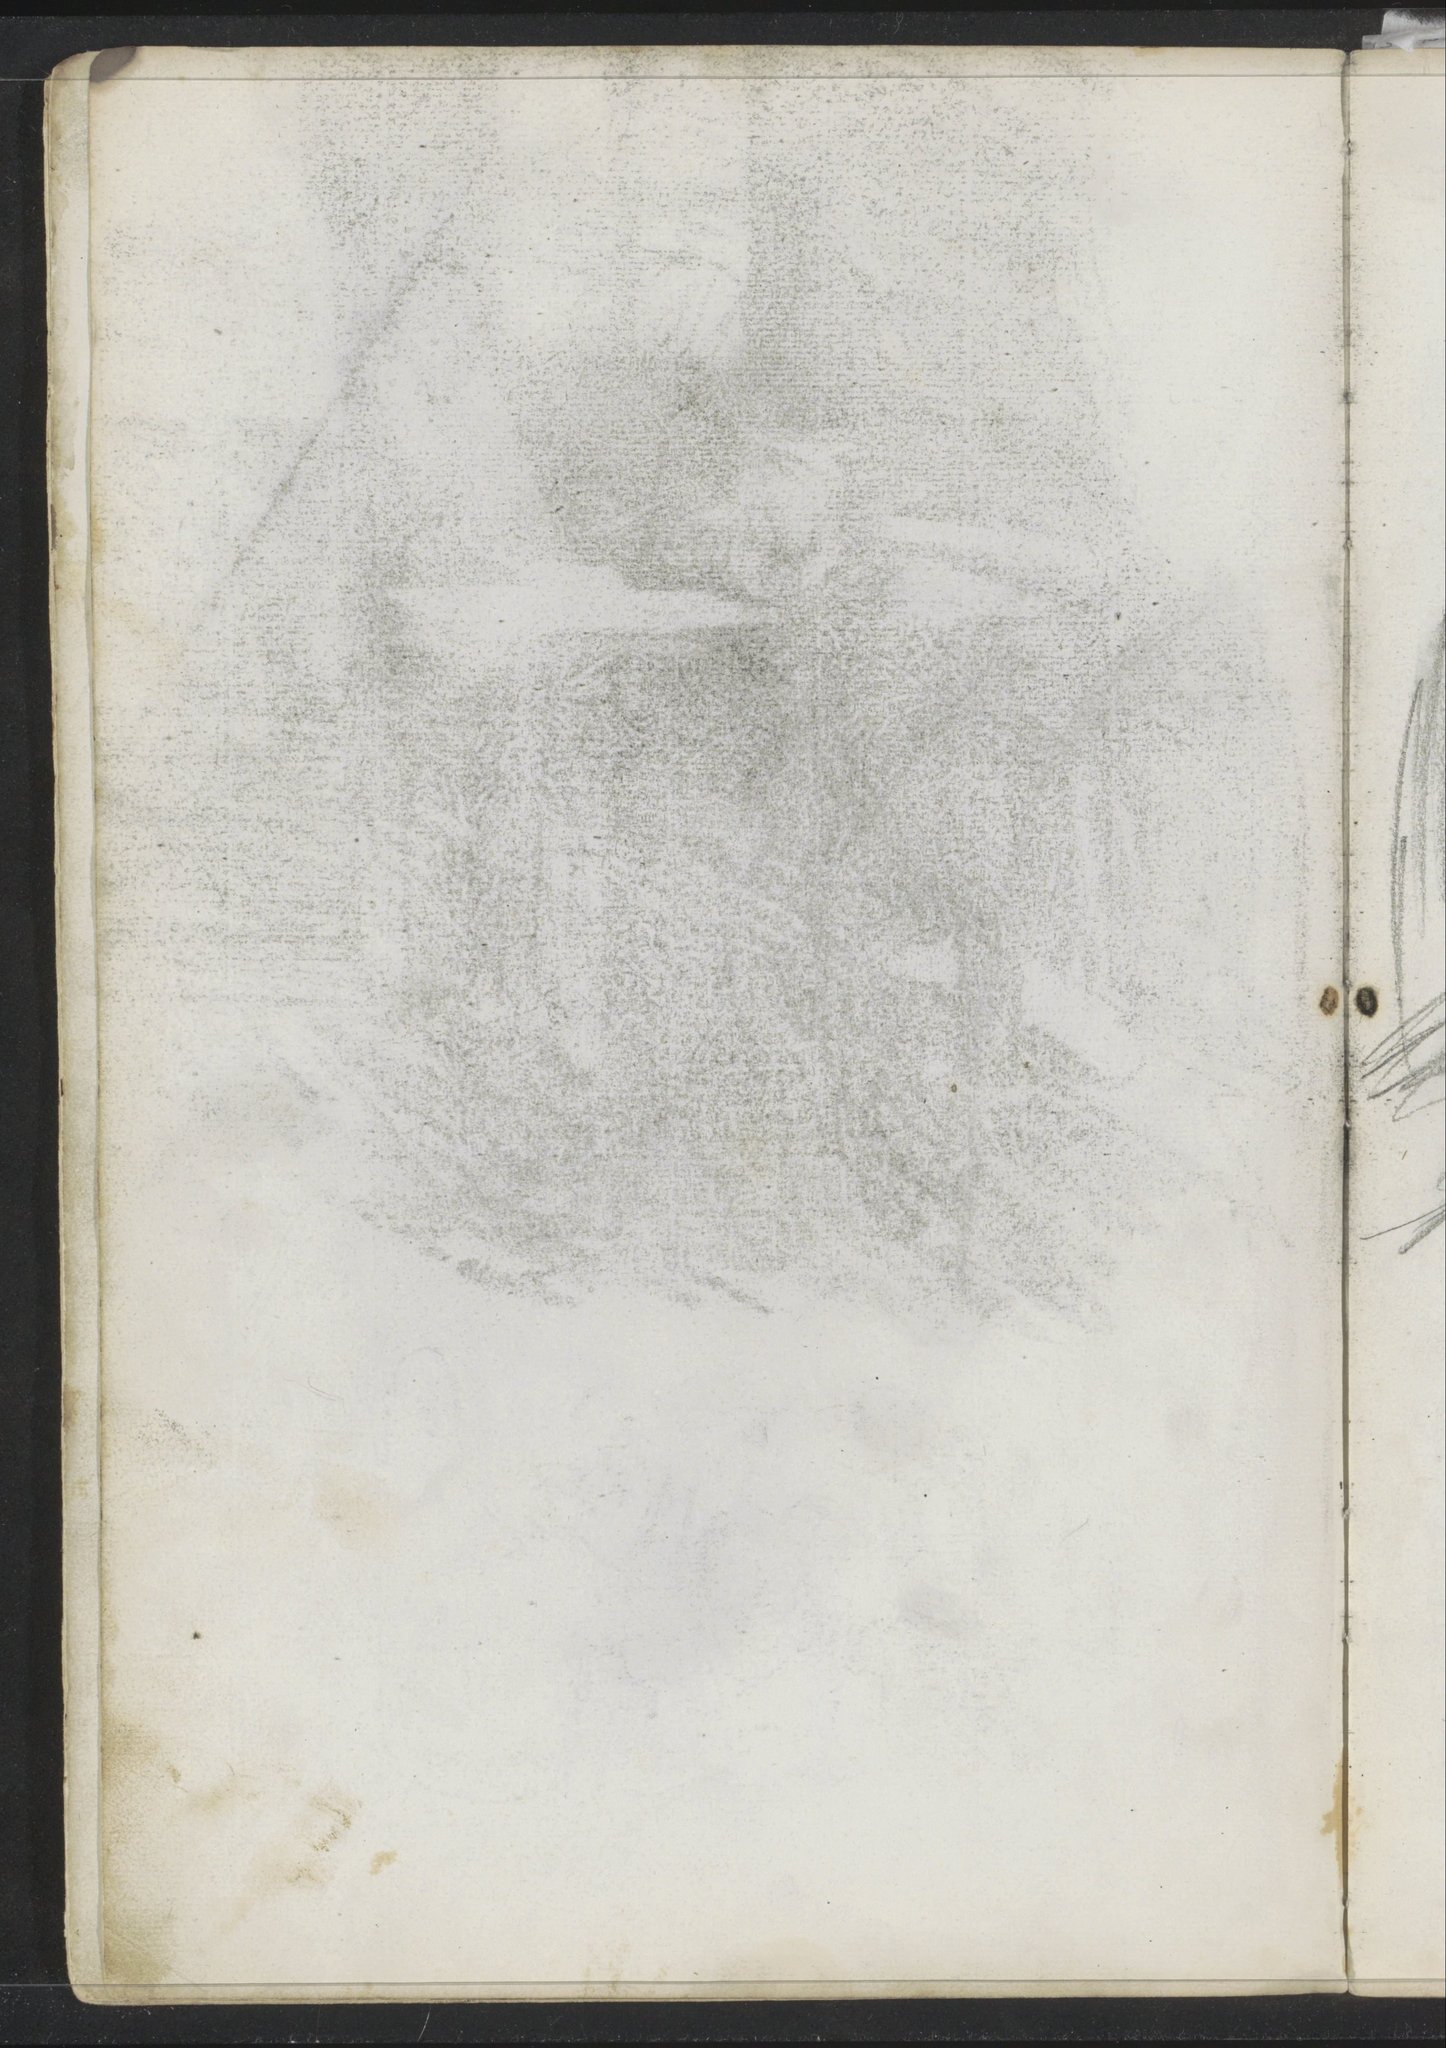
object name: sketchbook leaf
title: Abklatsch van de potloodtekening op pagina 6 recto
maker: jozef israëls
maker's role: draughtsman, painter, print maker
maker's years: 1824-1911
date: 1855-1859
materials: paper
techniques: printmaking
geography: zandvoort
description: Blad 5 verso uit een schetsboek met 22 bladen.